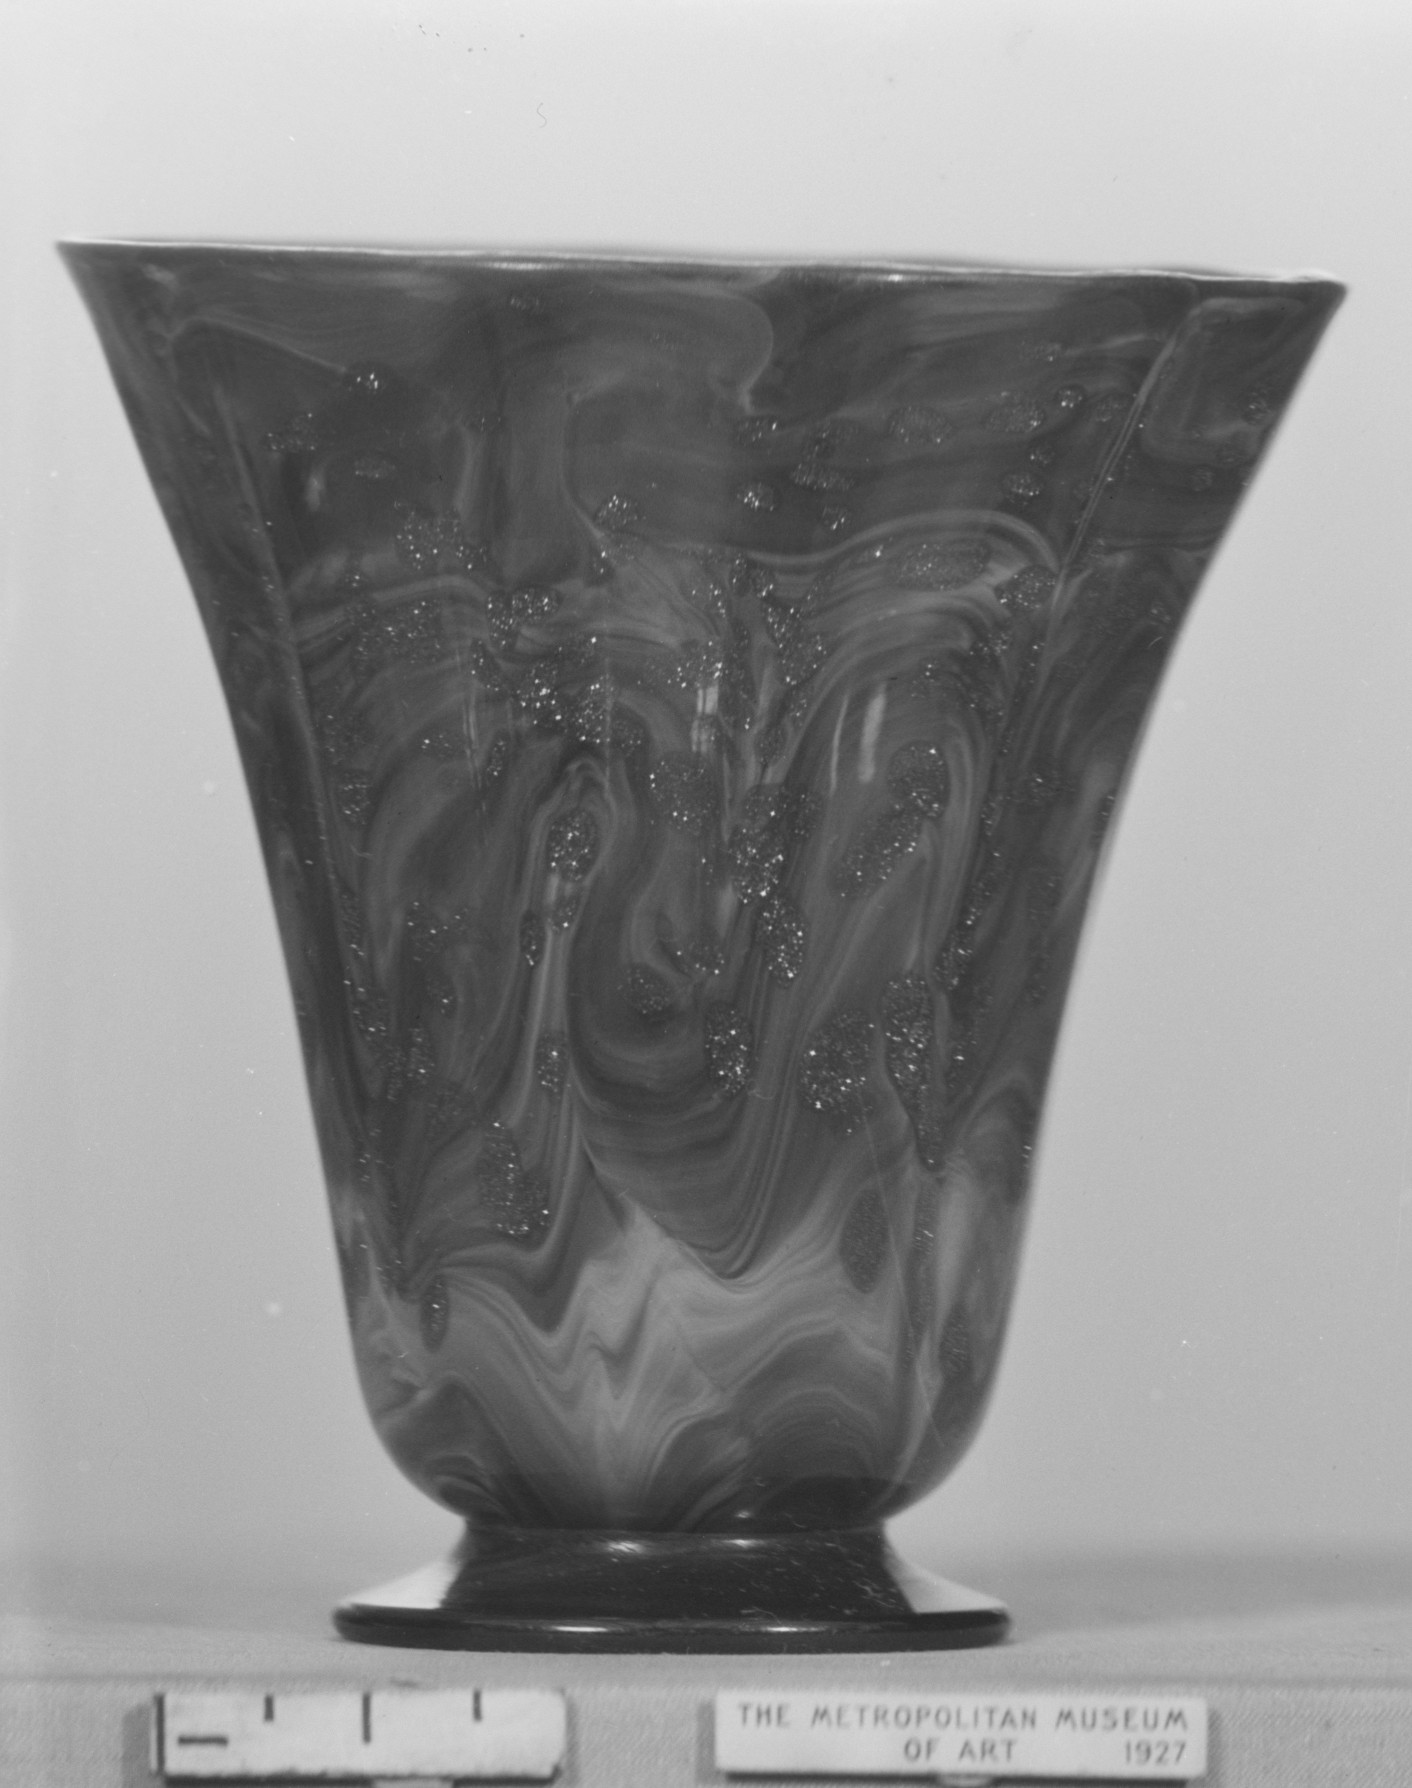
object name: beaker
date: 1601-1800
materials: glass